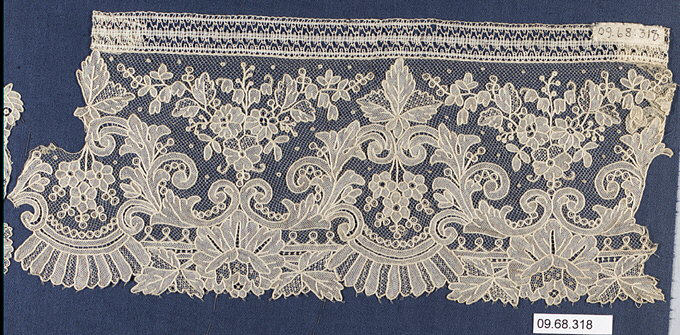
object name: specimen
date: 1801-1900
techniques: lace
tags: flowers,leaves